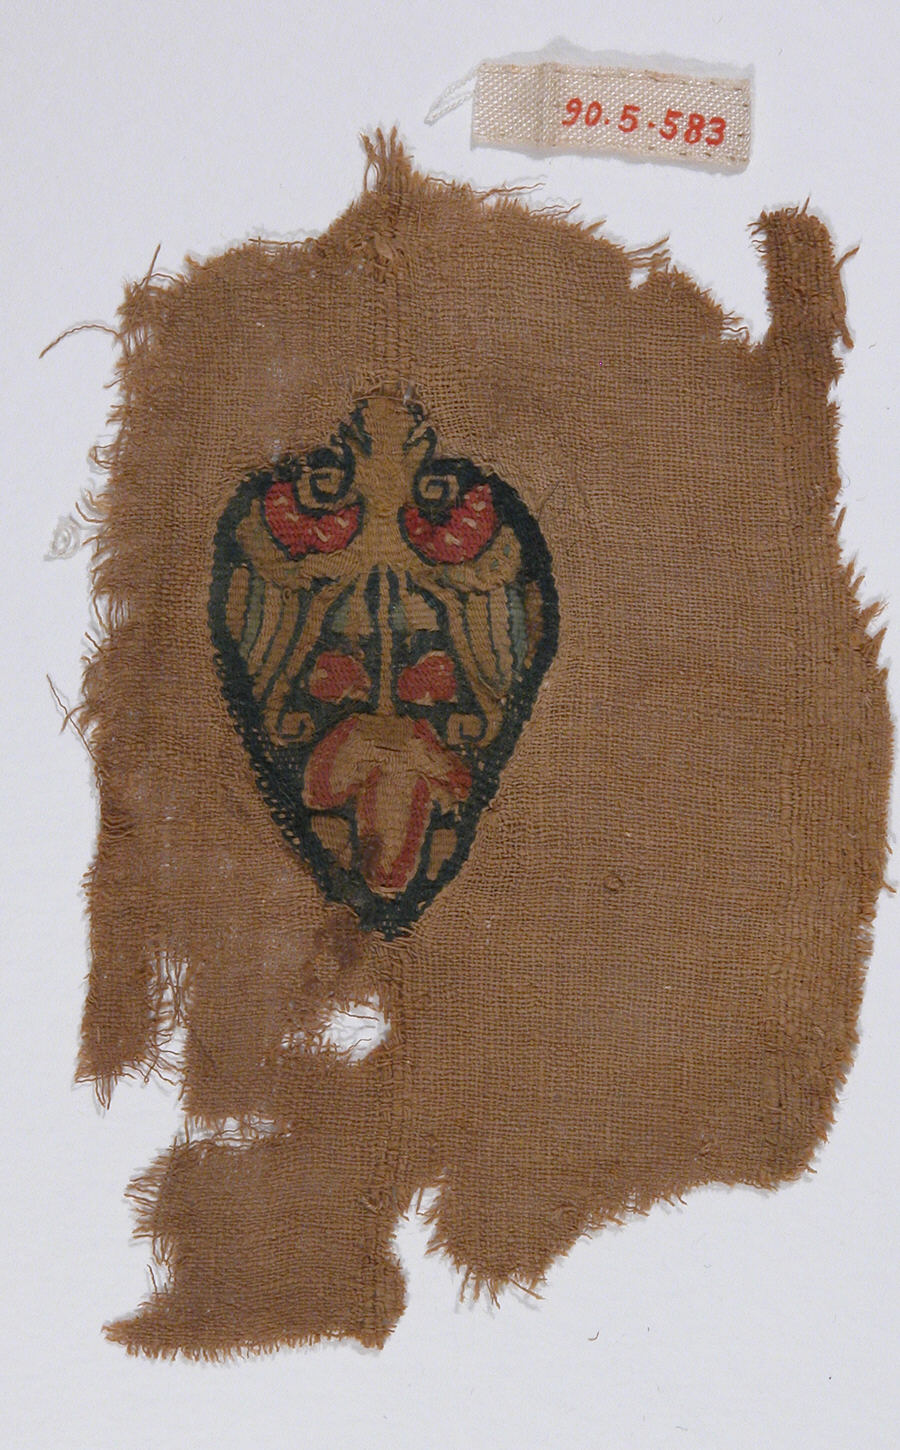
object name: textile fragment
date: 401-600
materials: linen, wool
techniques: weave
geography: egypt